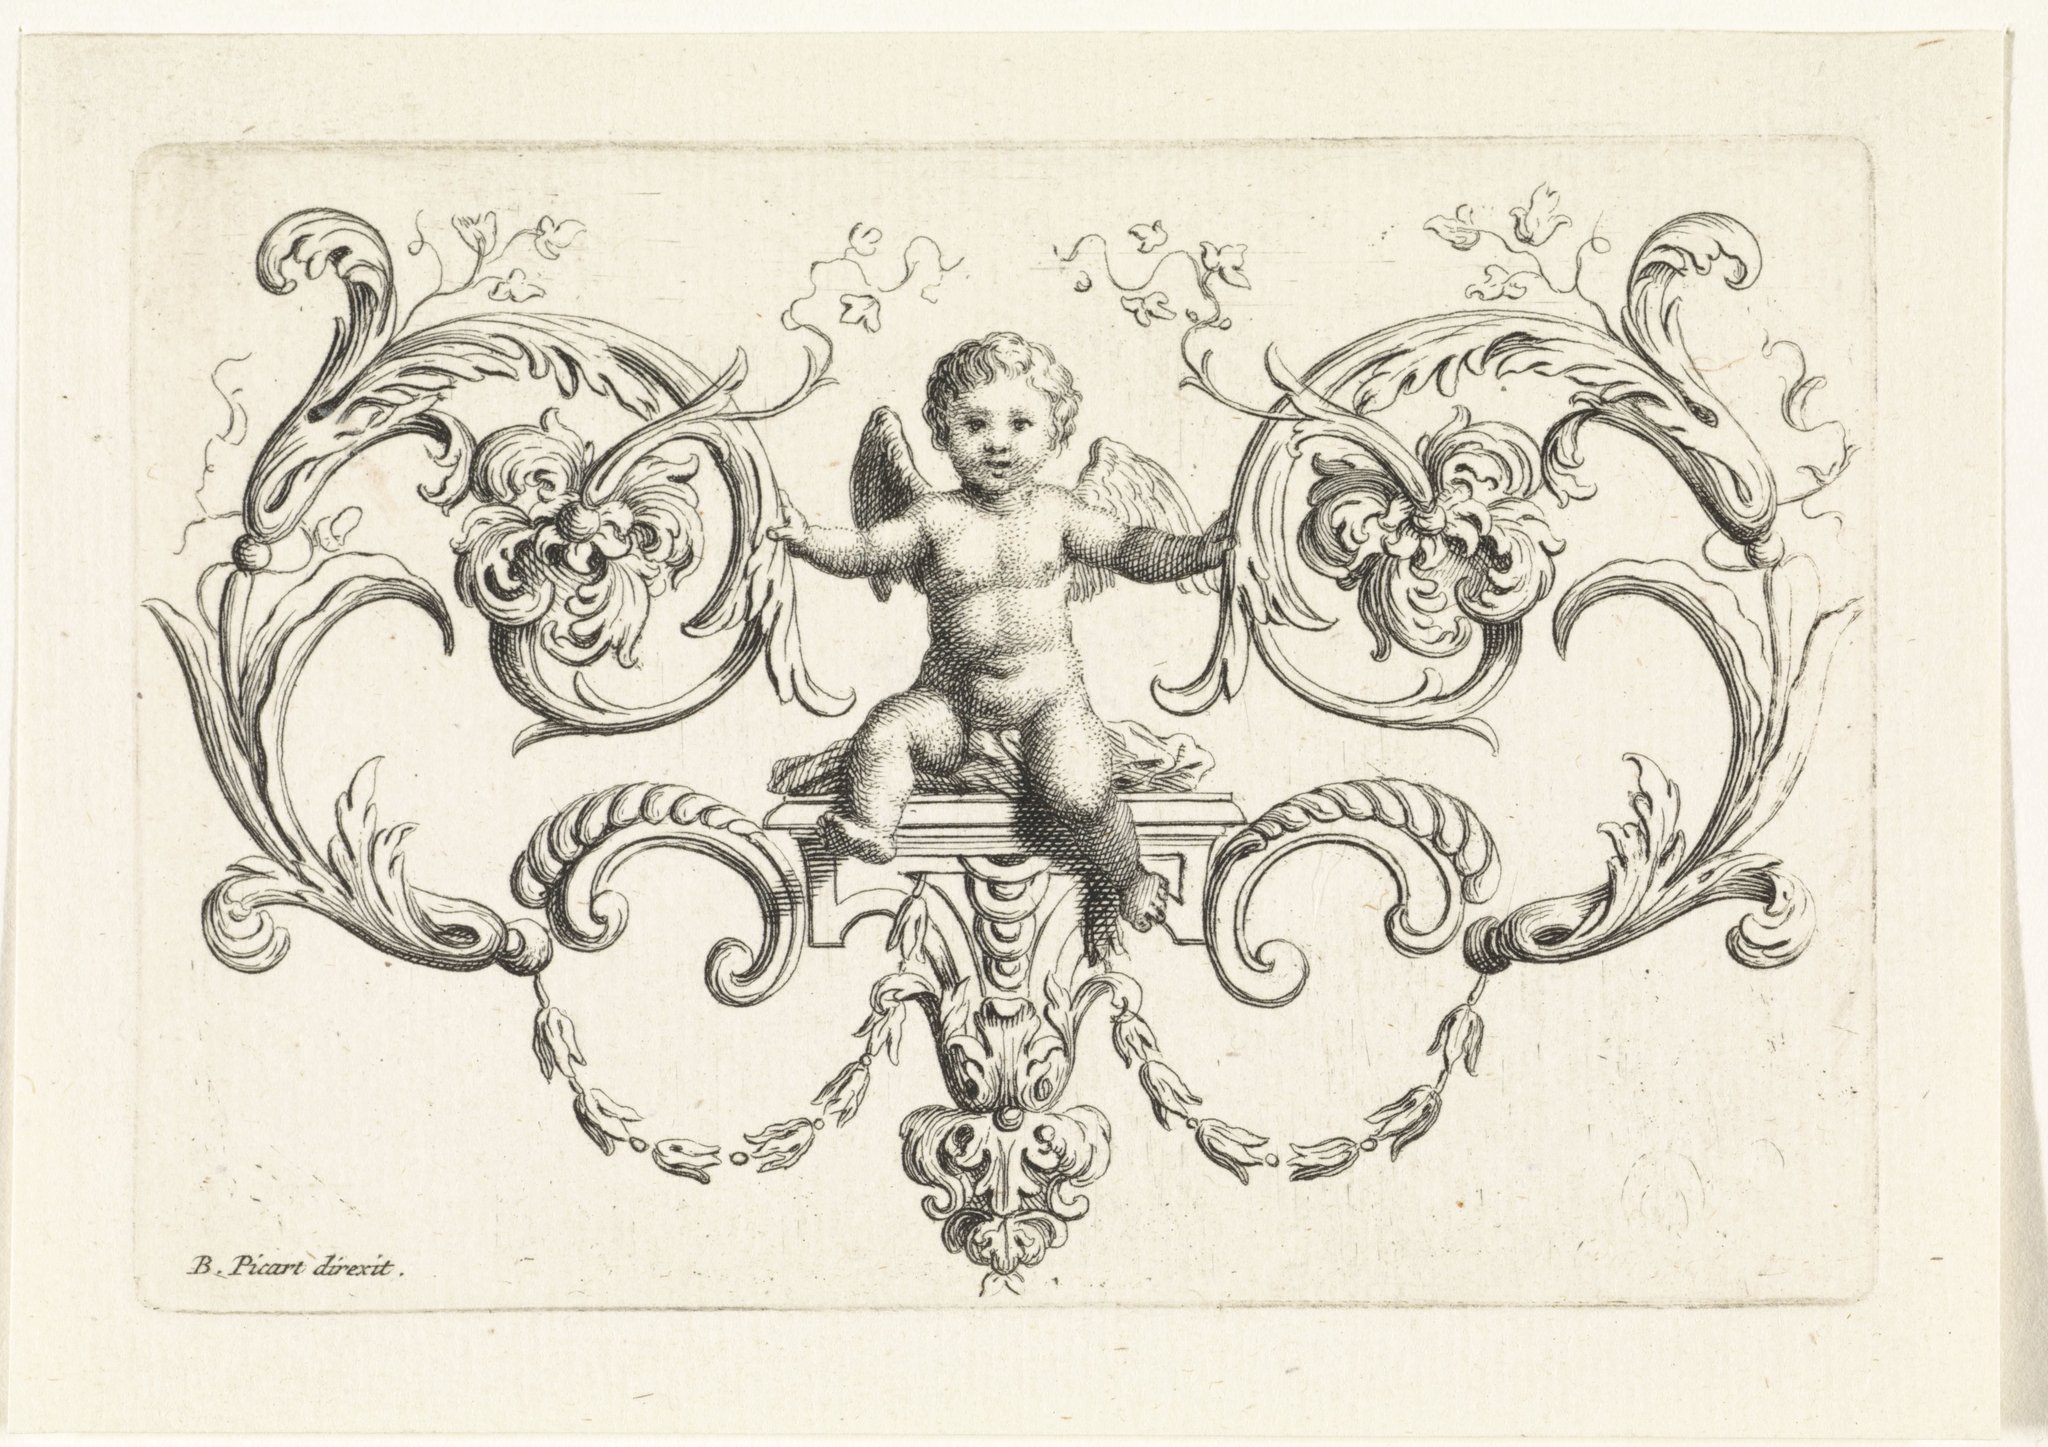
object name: print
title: Bladornament met zittende putto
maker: bernard picart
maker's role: draughtsman, print maker, publisher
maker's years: 1673-1733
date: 1683-1733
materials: paper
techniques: engraving, etching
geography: amsterdam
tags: foliage, tendrils, branches ~ ornament, cupids: 'amores', 'amoretti', 'putti'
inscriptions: collector's mark: Lugt 2233